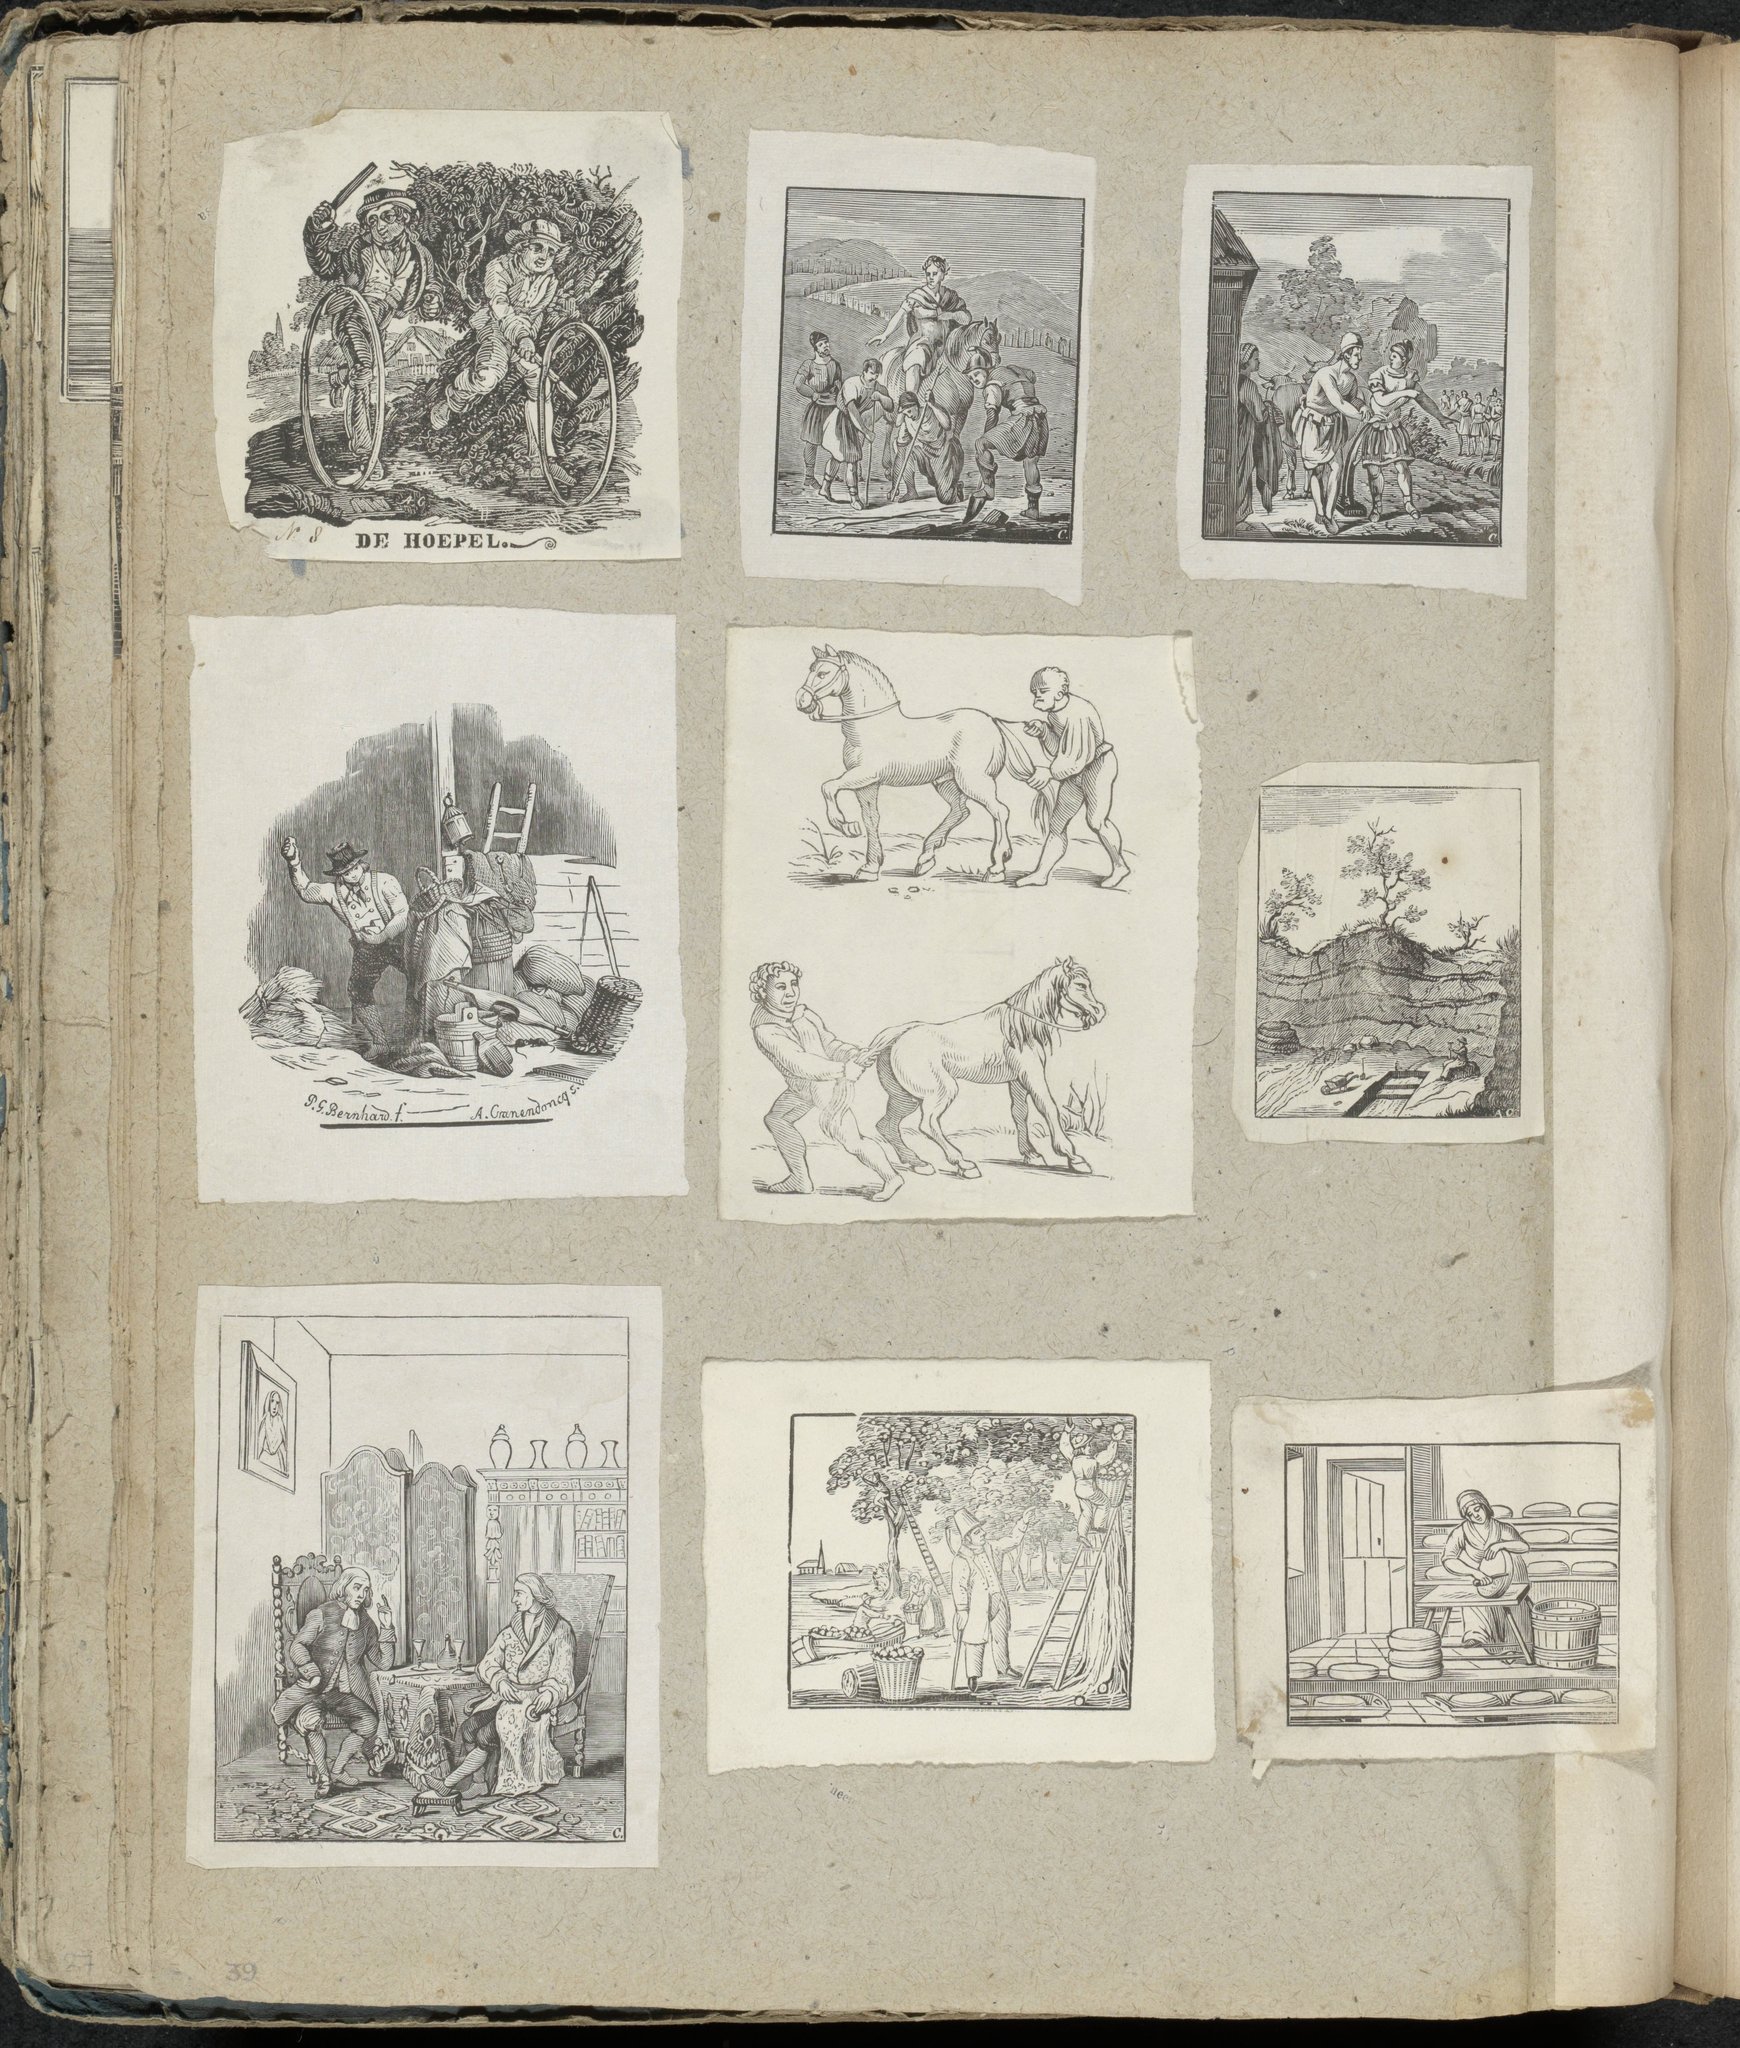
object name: album leaf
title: Albumblad met diverse voorstellingen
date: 1814-1869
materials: paper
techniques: snipping, engraving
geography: nijmegen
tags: picking fruit, the soldier; the soldier's life, horse, cheese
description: Albumblad met 9 uitgeknipte voorstellingen uit voornamelijk volksprenten, onder andere van hoepelende kinderen, Romeinen, een boer die muizen probeert te vangen en van boeren die appels plukken.